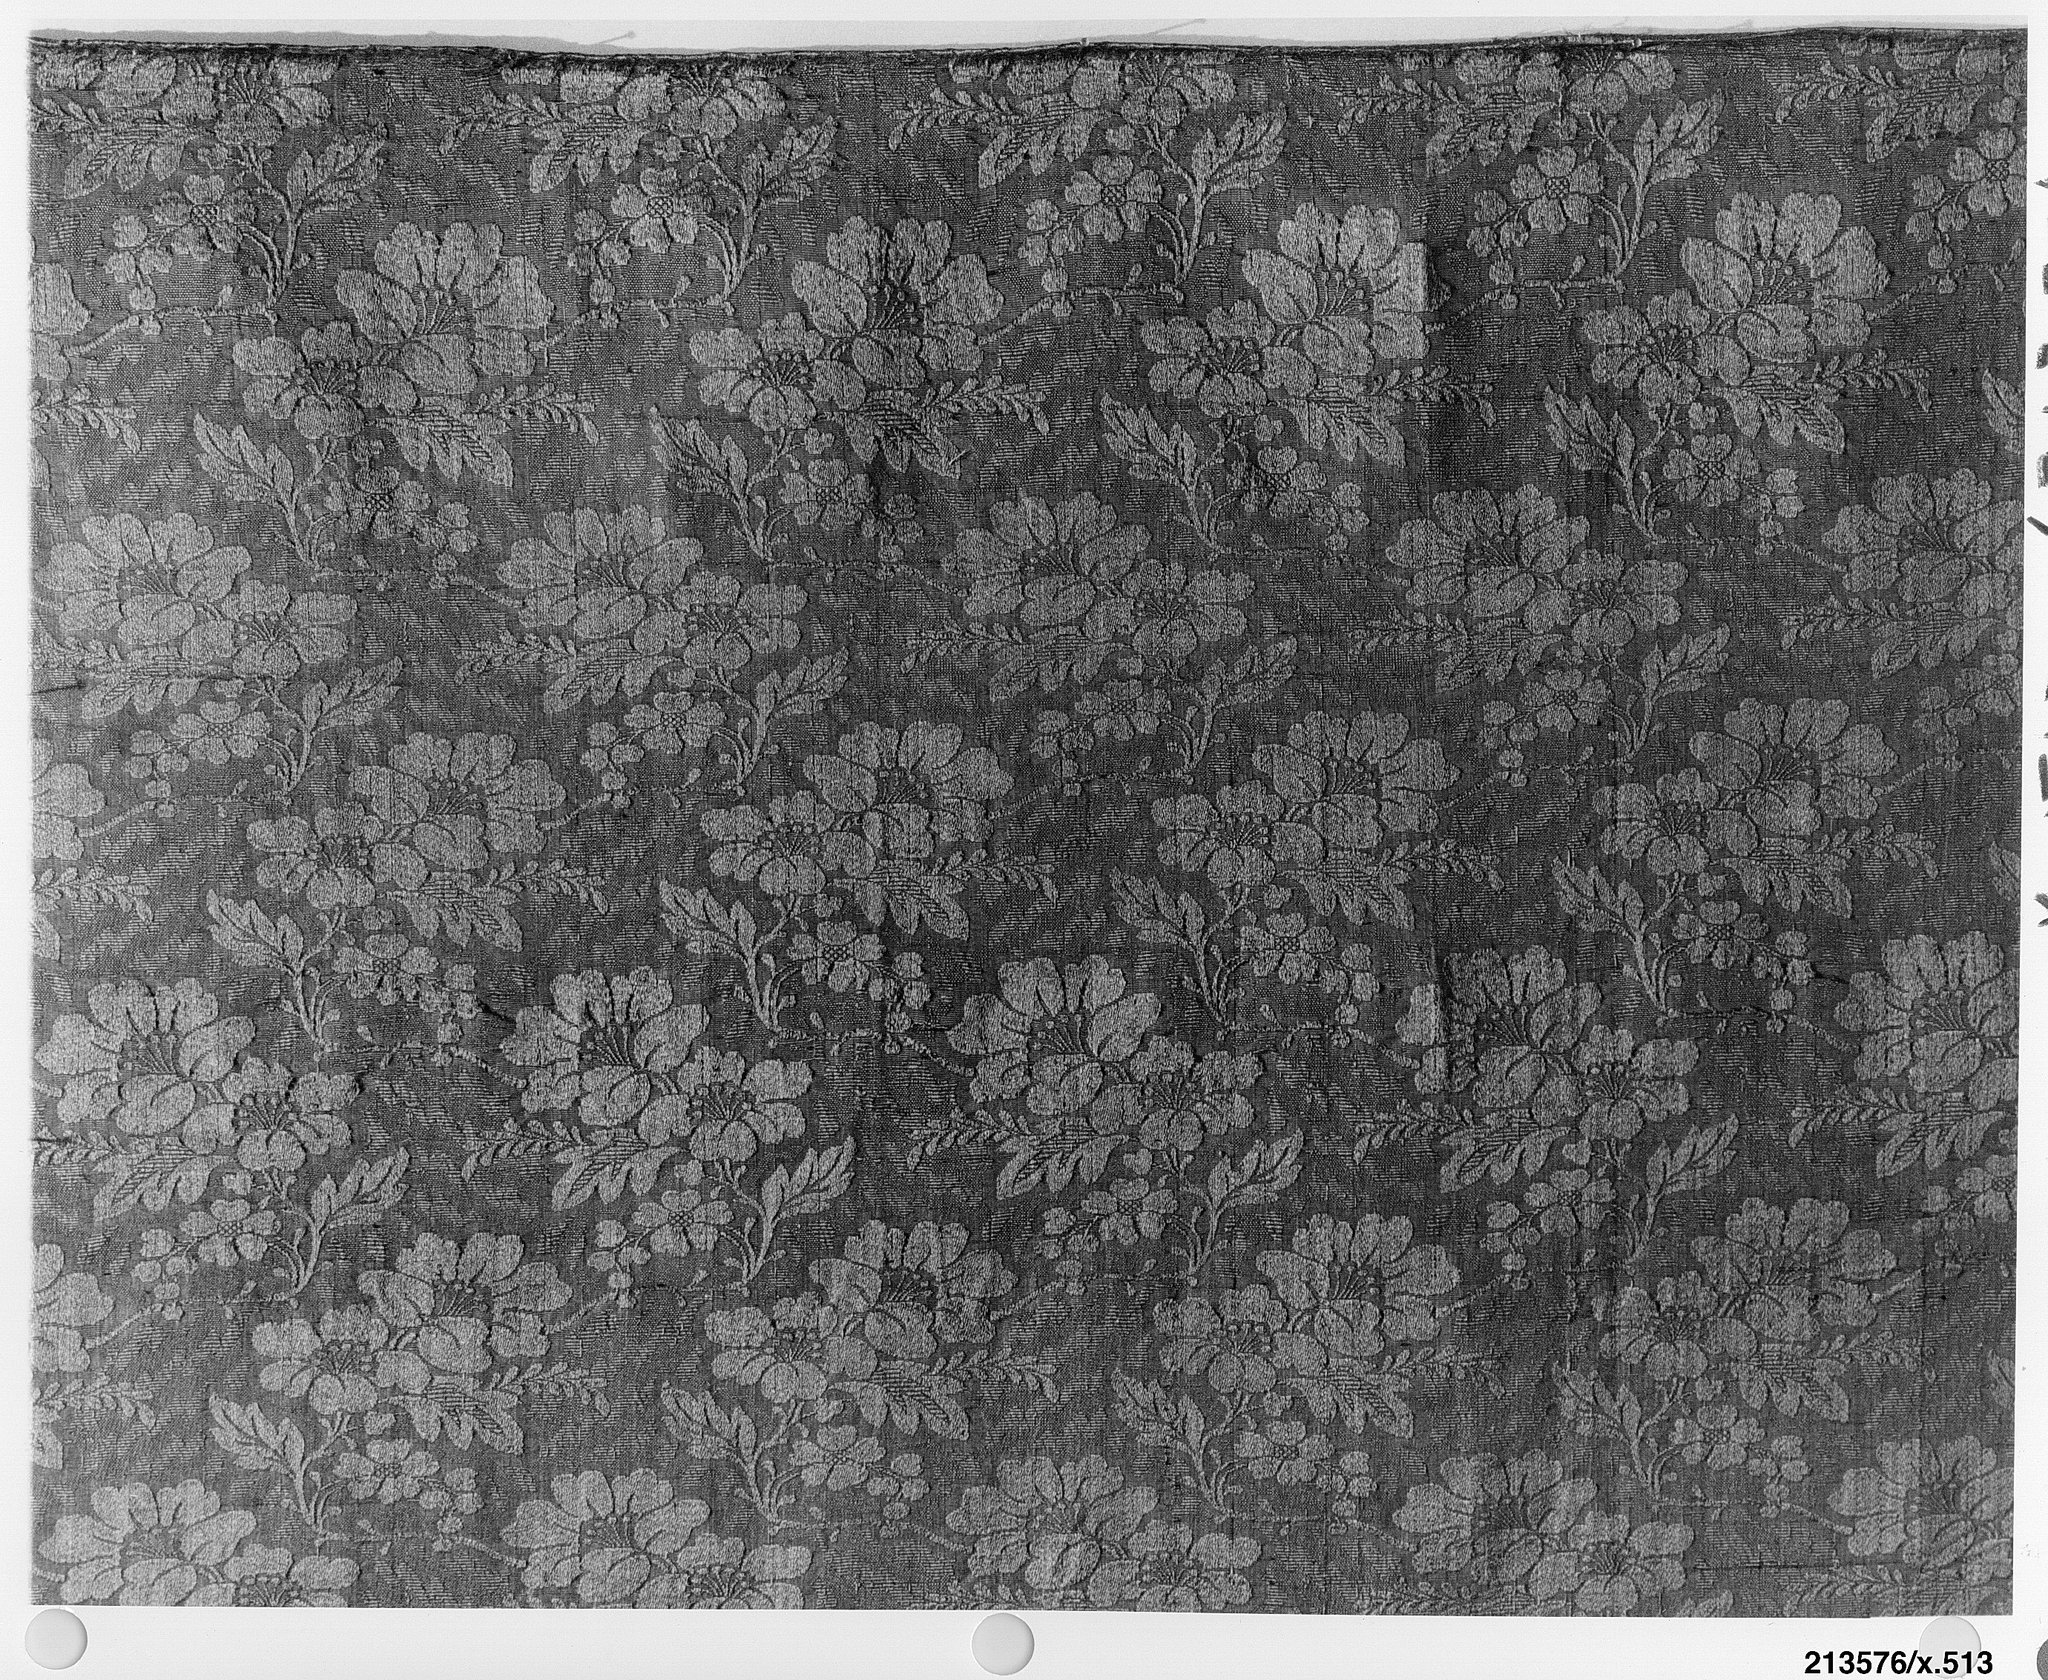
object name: breadth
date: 1701-1800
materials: silk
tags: flowers